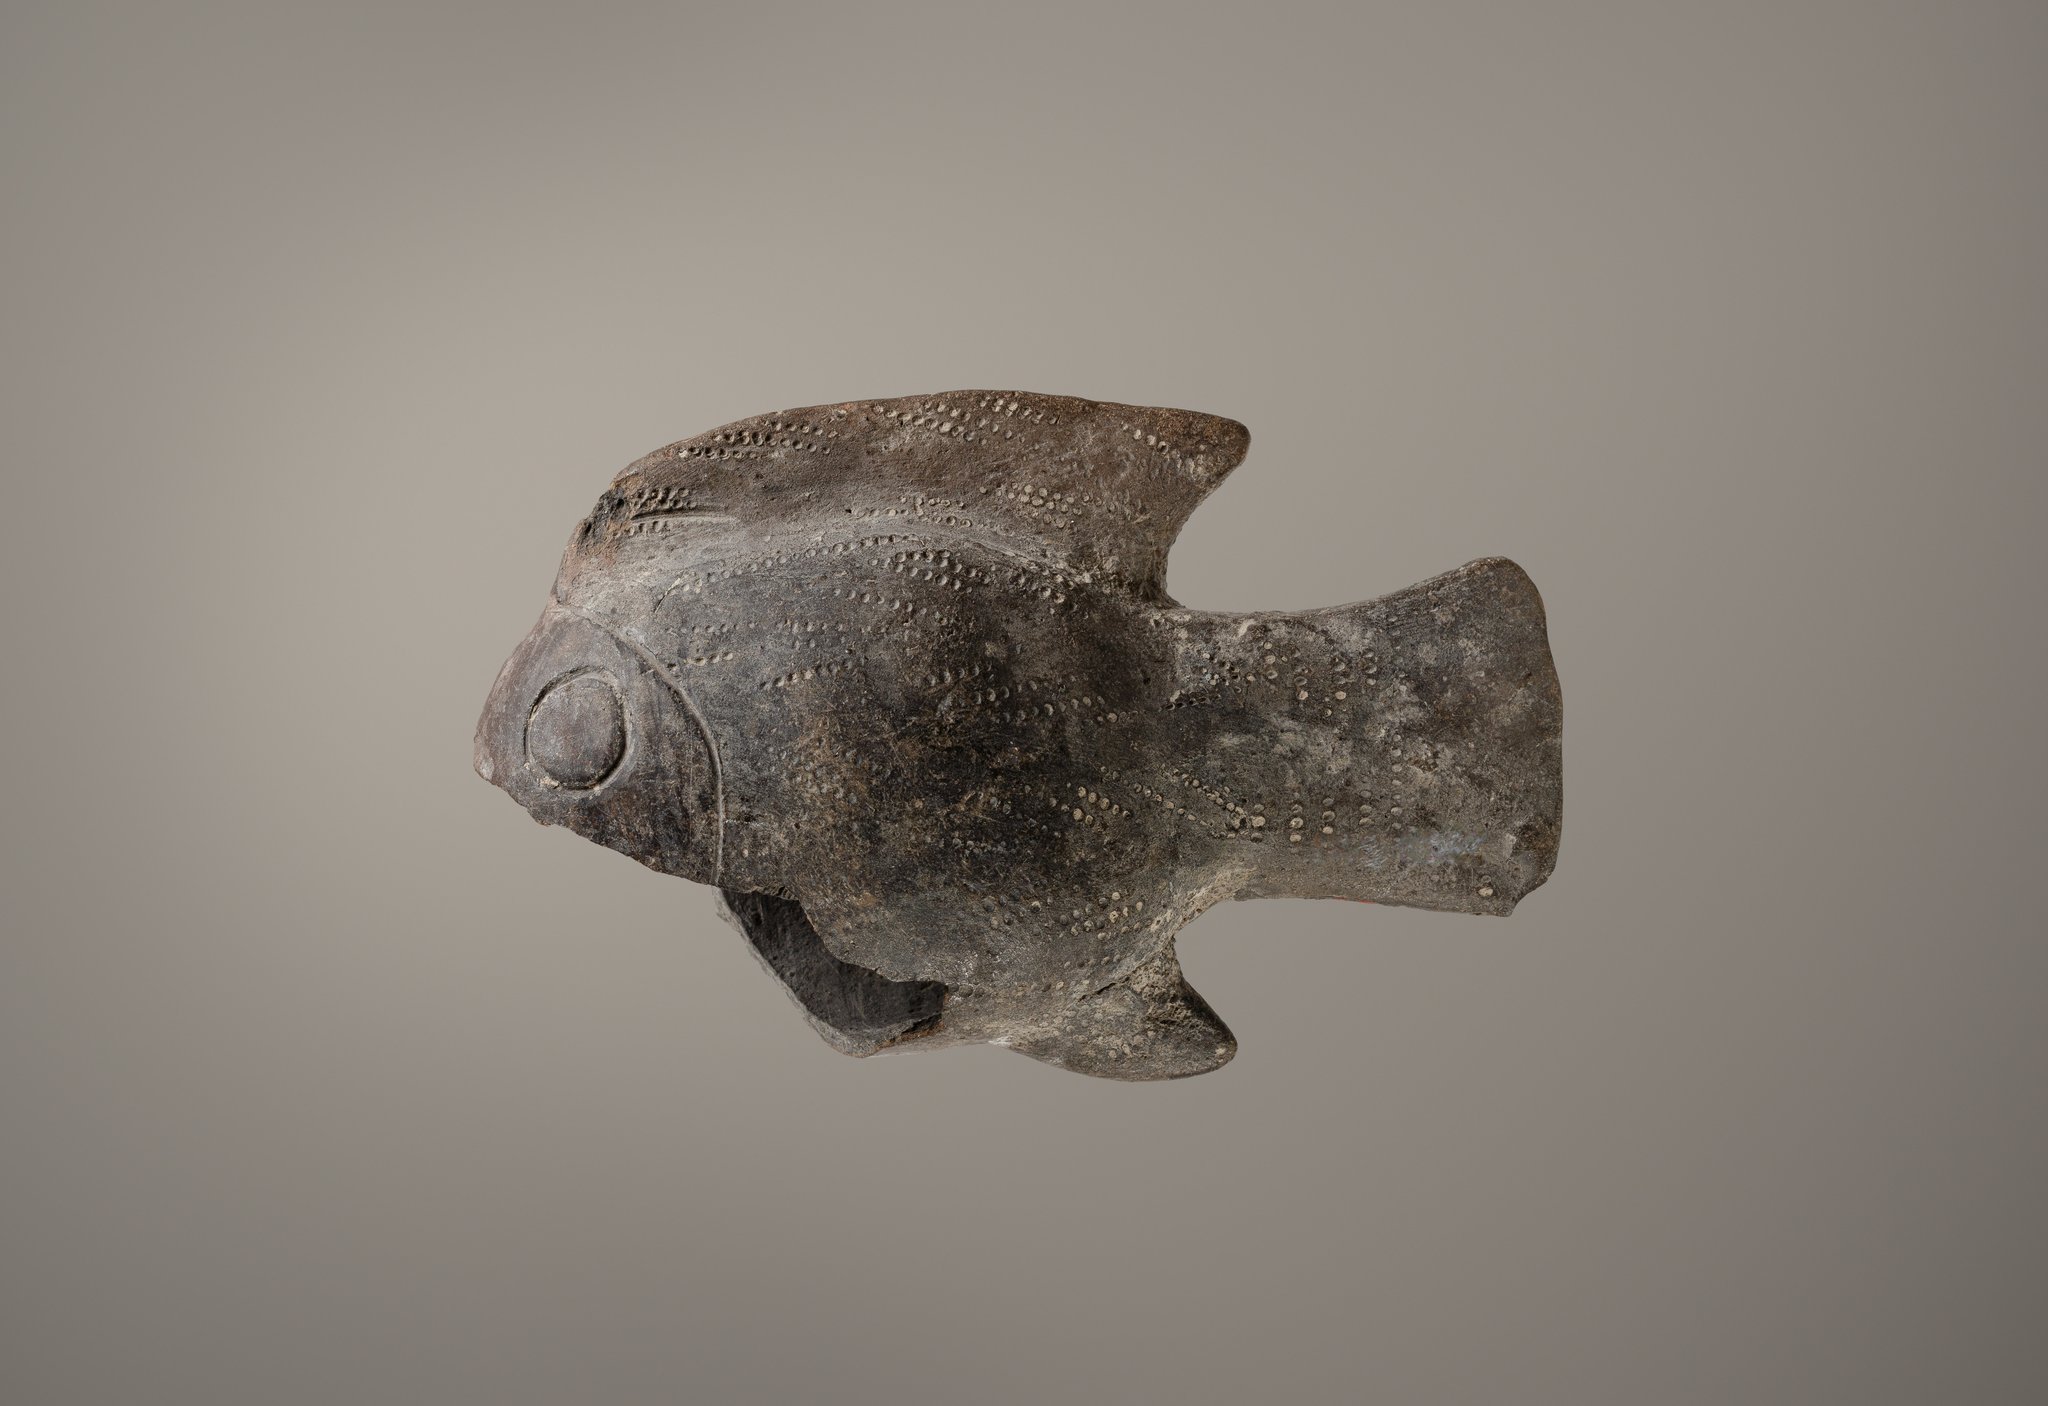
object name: dish, tell el yahudiya ware, fish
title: Tell el-Yahudiya-ware fish vessel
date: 1640-1550 BCE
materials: pottery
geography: egypt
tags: fish